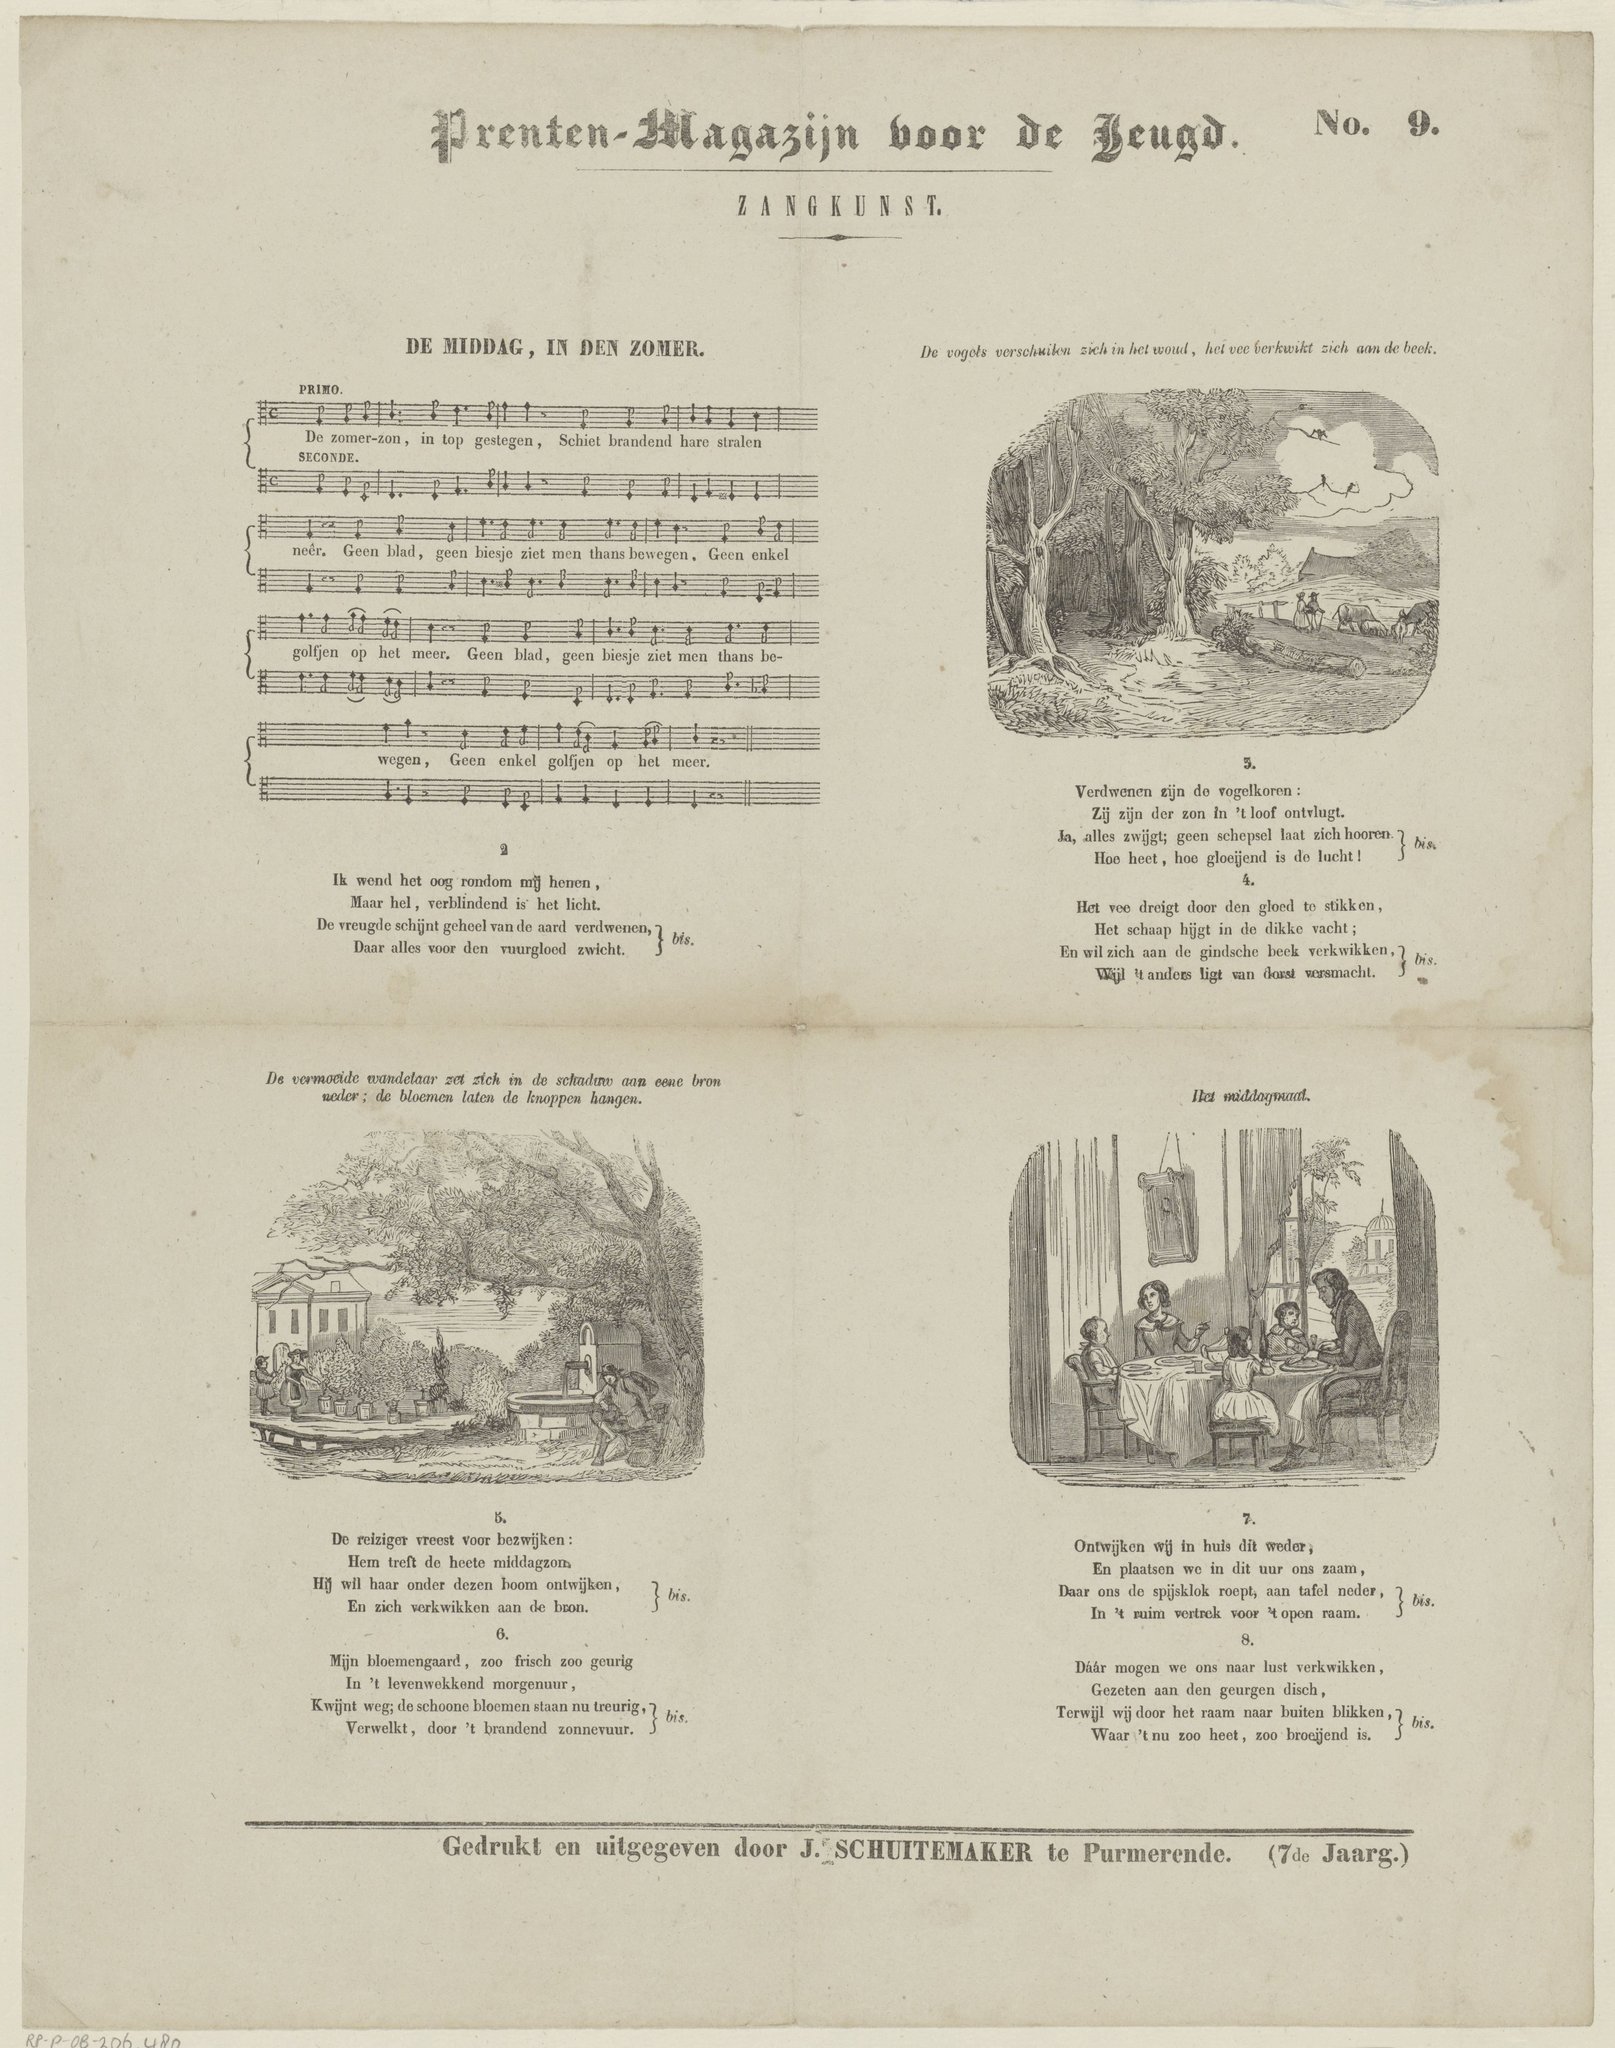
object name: popular print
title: Zangkunst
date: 1848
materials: paper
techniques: letterpress printing, engraving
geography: purmerend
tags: summer landscape; landscape symbolizing summer (the four seasons of the year), afternoon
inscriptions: collector's mark: Lugt 2760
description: Blad met 3 voorstellingen en een stuk bladmuziek met een lied over een zomermiddag. Boven elke voorstelling een titel en onder elke voorstelling coupletten van het lied. Genummerd rechtsboven: No. 9.